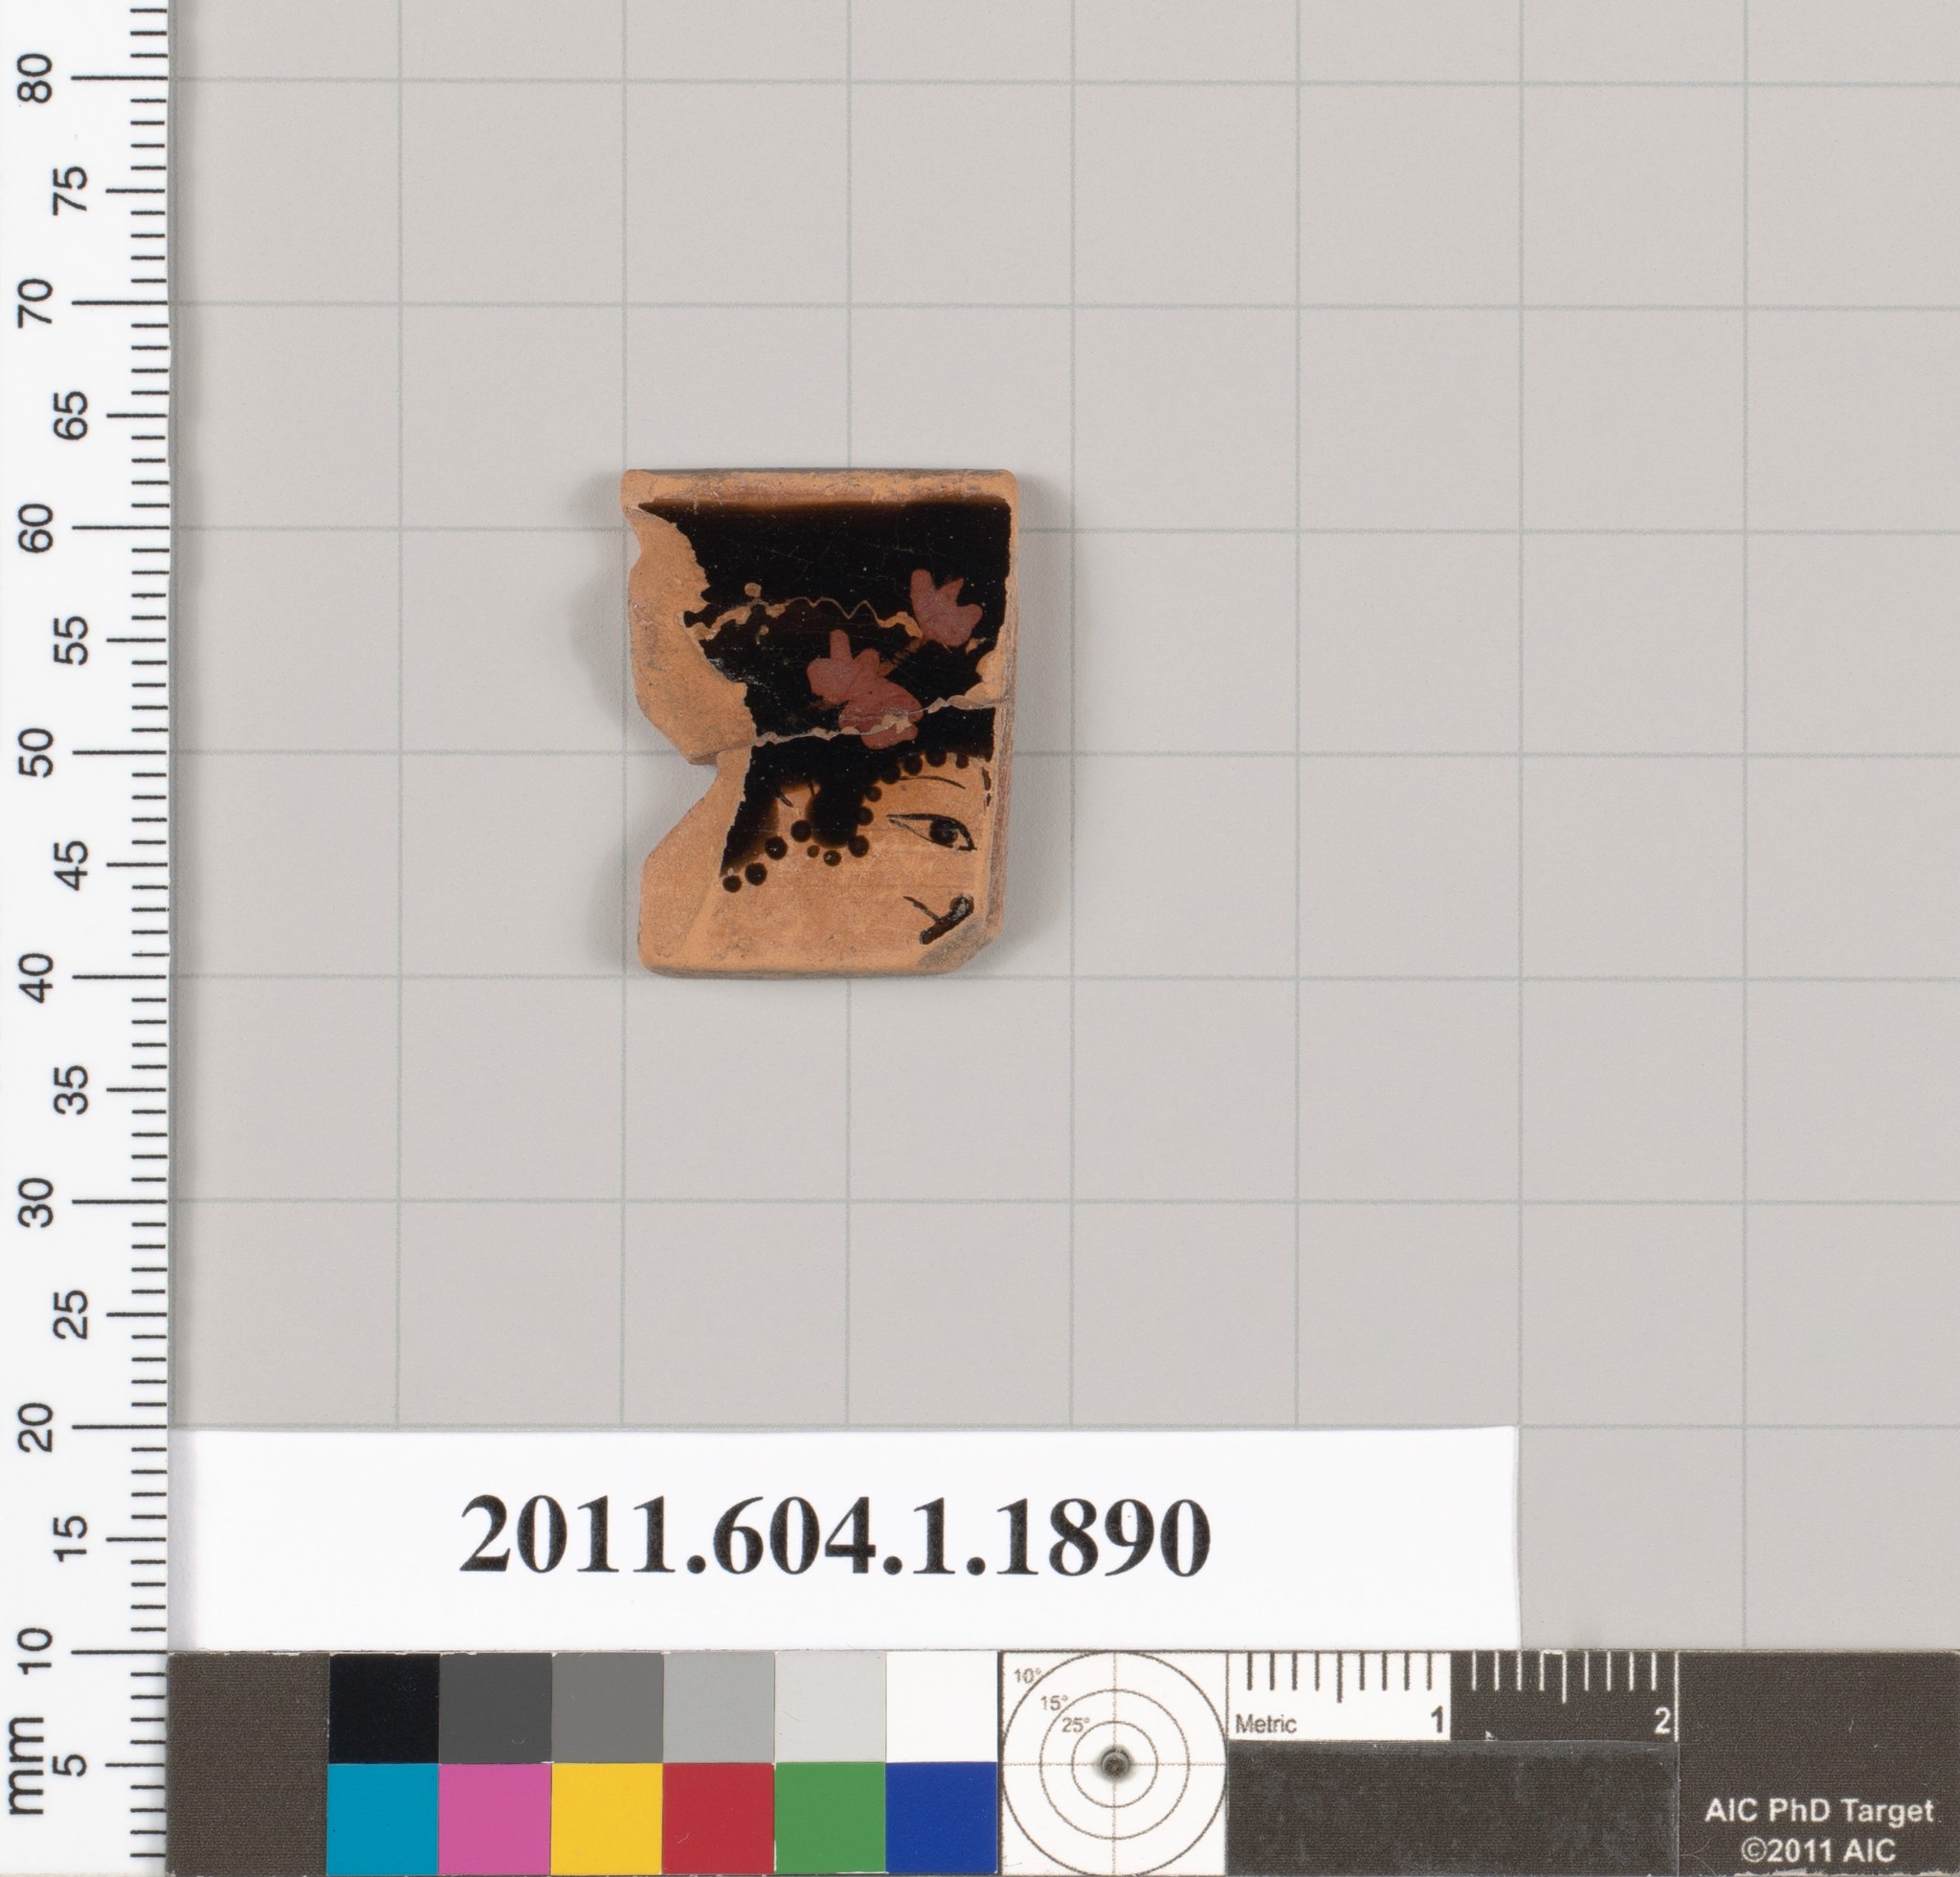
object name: kylix fragment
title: Terracotta rim fragment of a kylix (drinking cup)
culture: greek, attic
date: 520-510 BCE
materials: terracotta